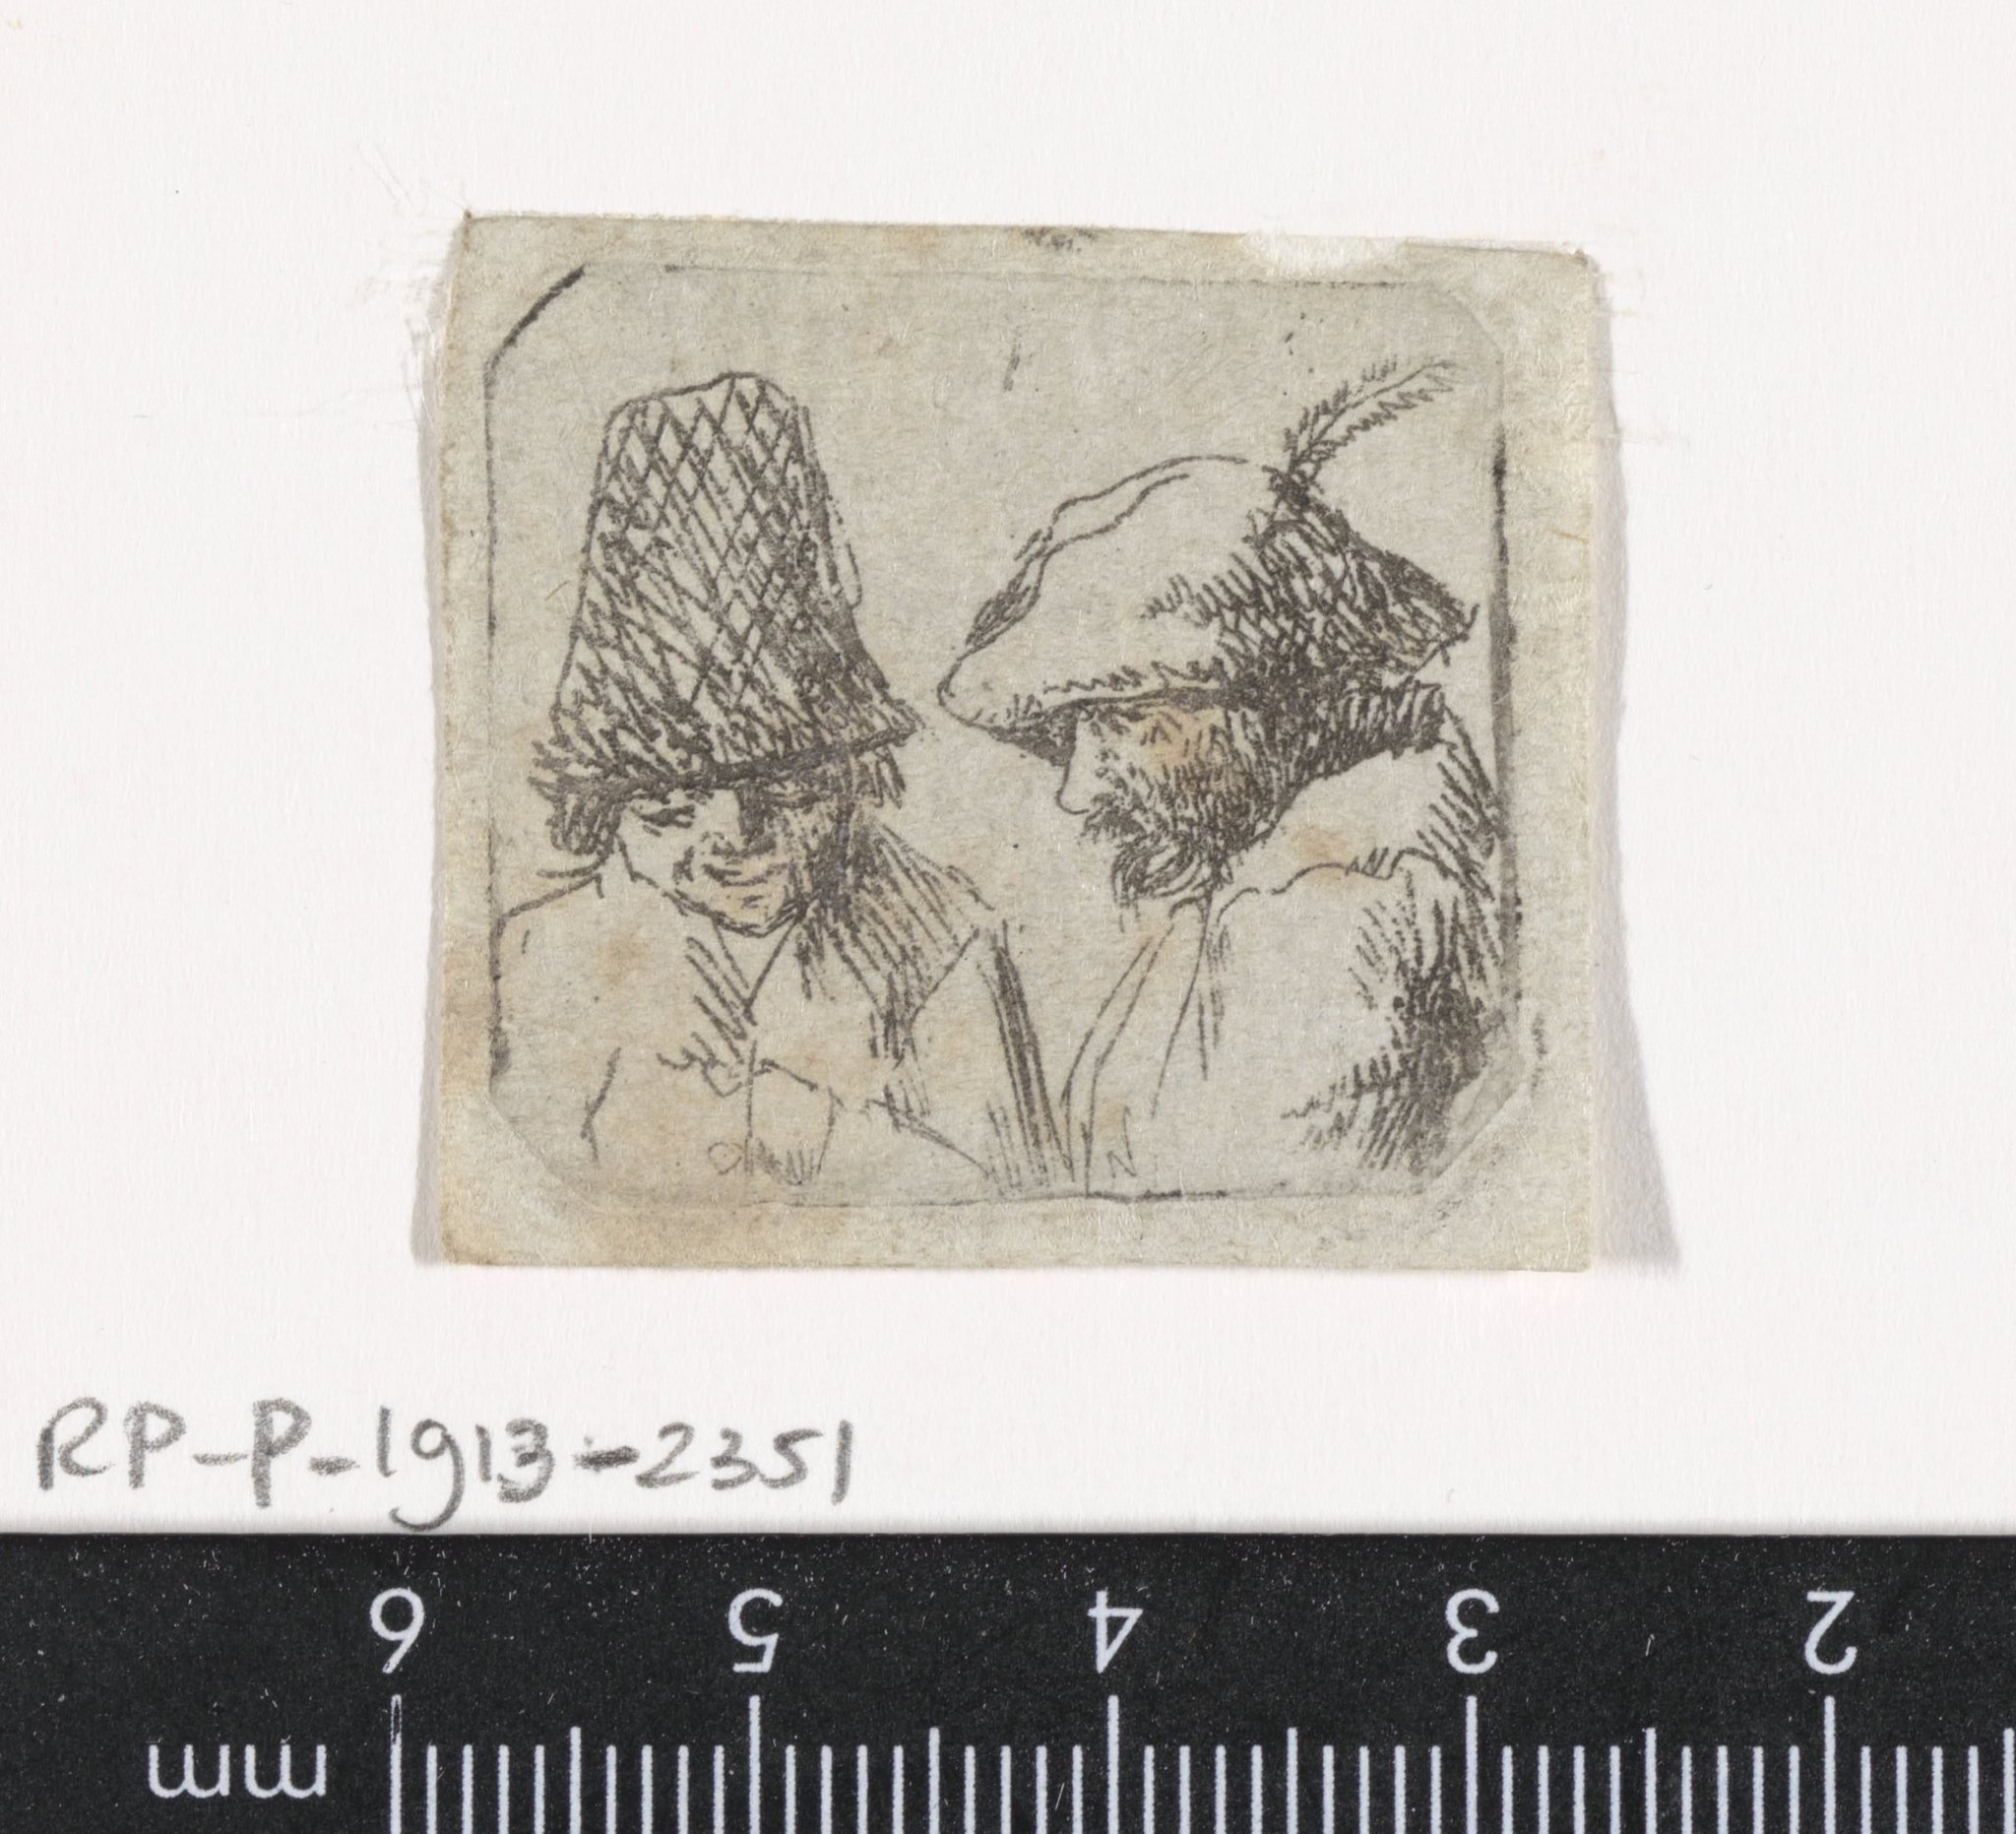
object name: print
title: Twee mannen, één met hoge muts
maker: antoon overlaet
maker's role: draughtsman, print maker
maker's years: 1720-1774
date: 1760-1774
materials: paper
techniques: etching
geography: antwerp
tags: head-gear: cap (+ men's clothes)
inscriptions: collector's mark: Lugt 2228